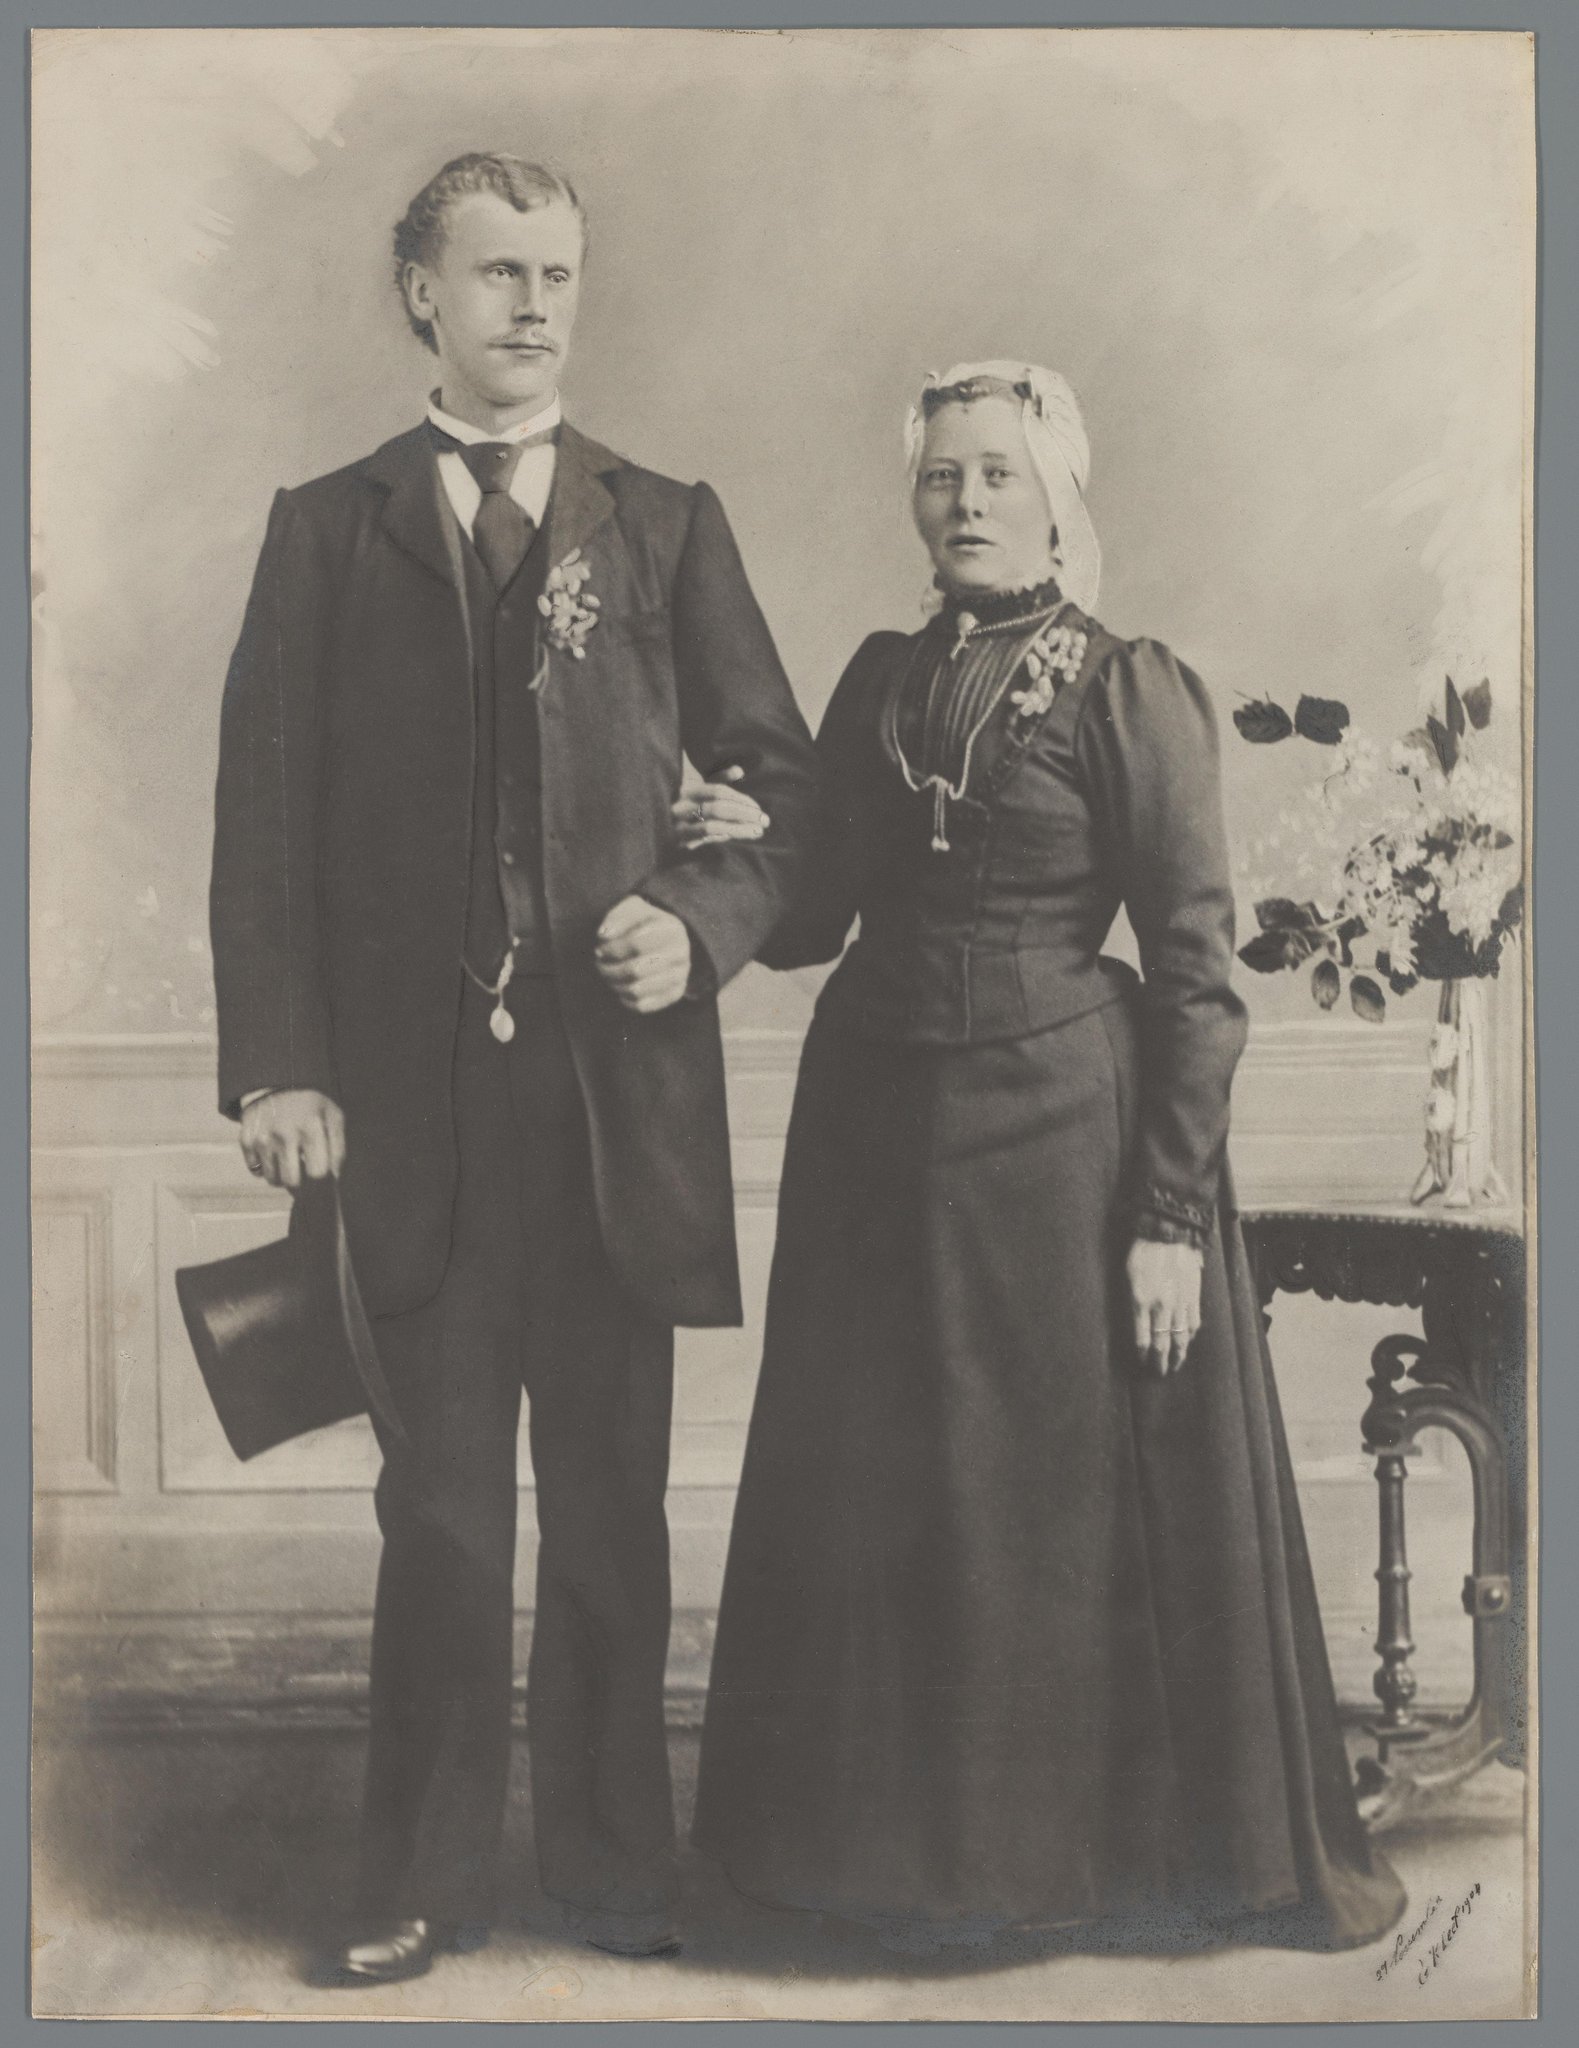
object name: photograph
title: Portret van een onbekend echtpaar in klederdracht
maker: Anonymous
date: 1904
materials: paper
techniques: gelatin silver print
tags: marriage, married couple, 'matrimonium', anonymous historical person portrayed, folk costume, regional costume